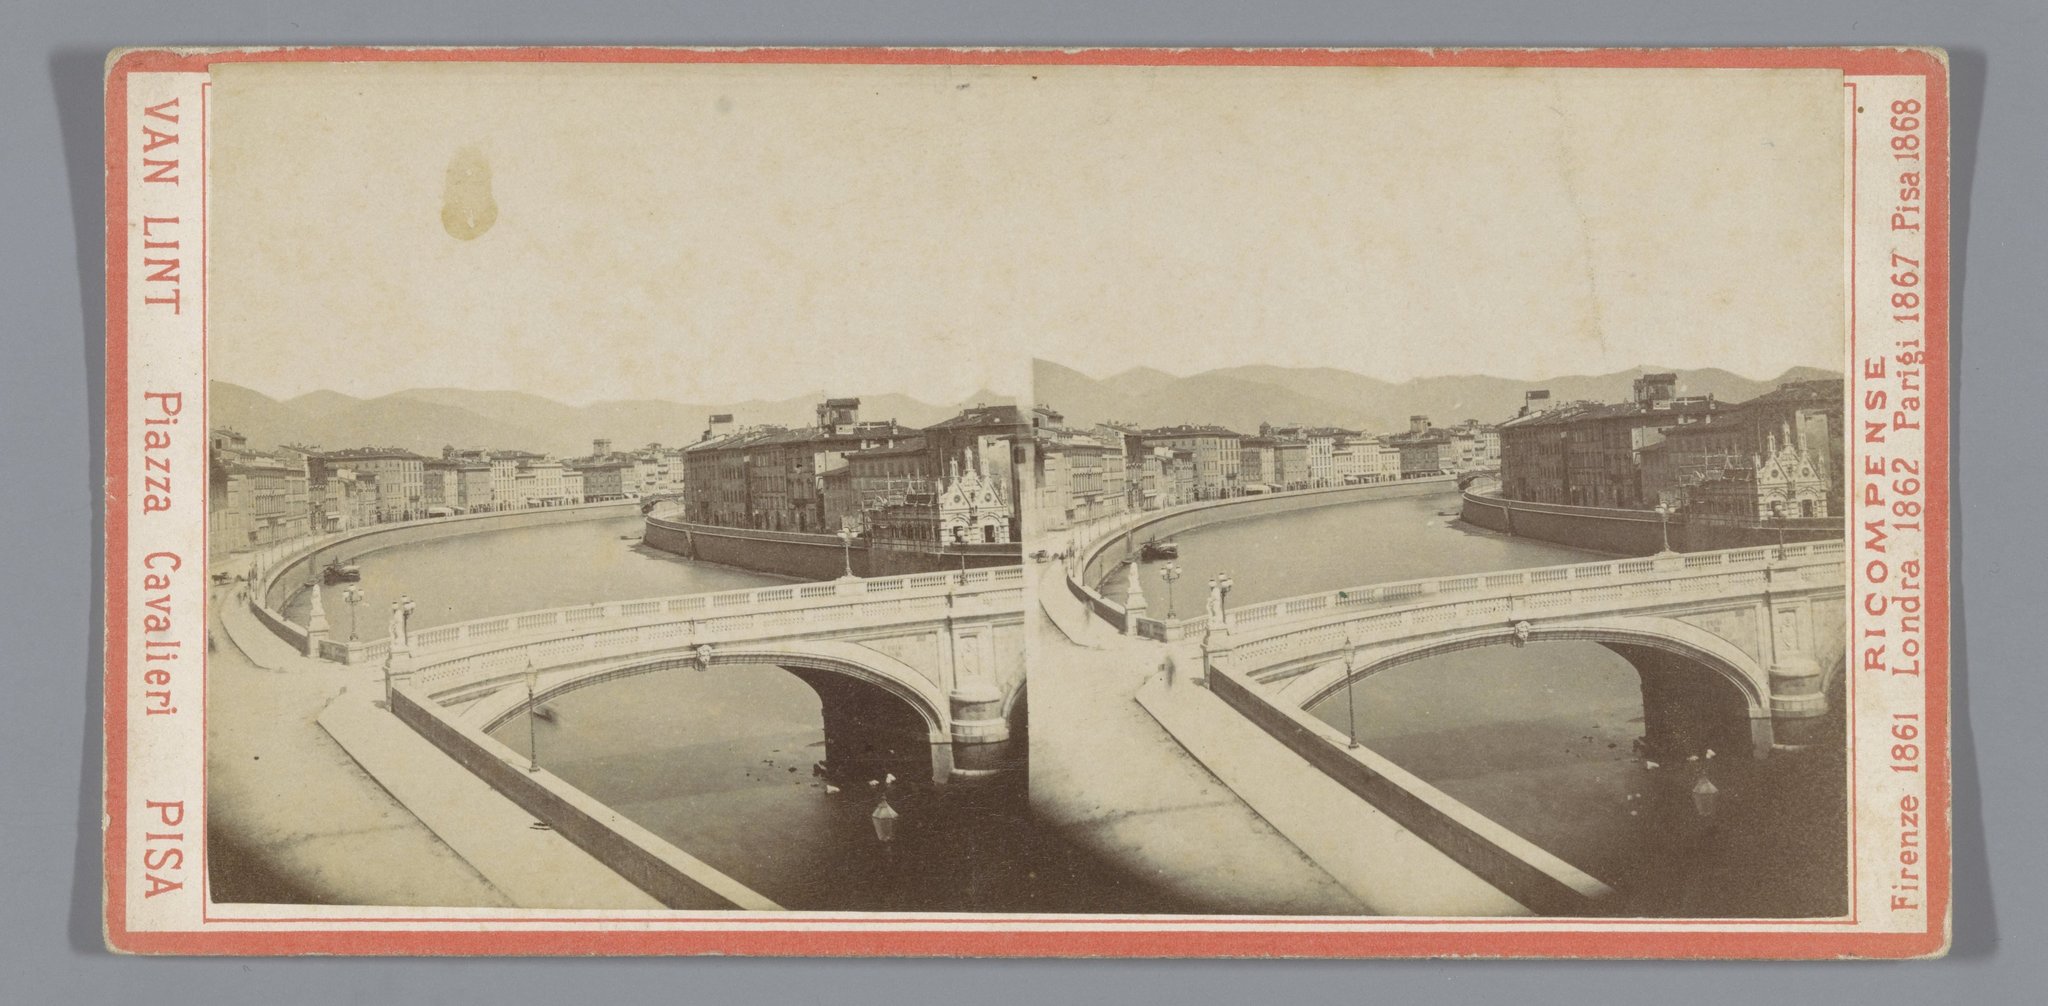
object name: stereograph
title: Gezicht op de Arno te Pisa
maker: enrico van lint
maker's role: fotograaf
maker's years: 1808-1884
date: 1850-1880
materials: cardboard, photographic support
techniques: albumen print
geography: pisa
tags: city-view in general; 'veduta', landscape with bridge, viaduct or aqueduct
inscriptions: name: ‘VAN LINT Piazza Cavalieri PISA RICOMPENSE Firenze 1861 Londra 1862 Parigi 1867 Pisa 1868’